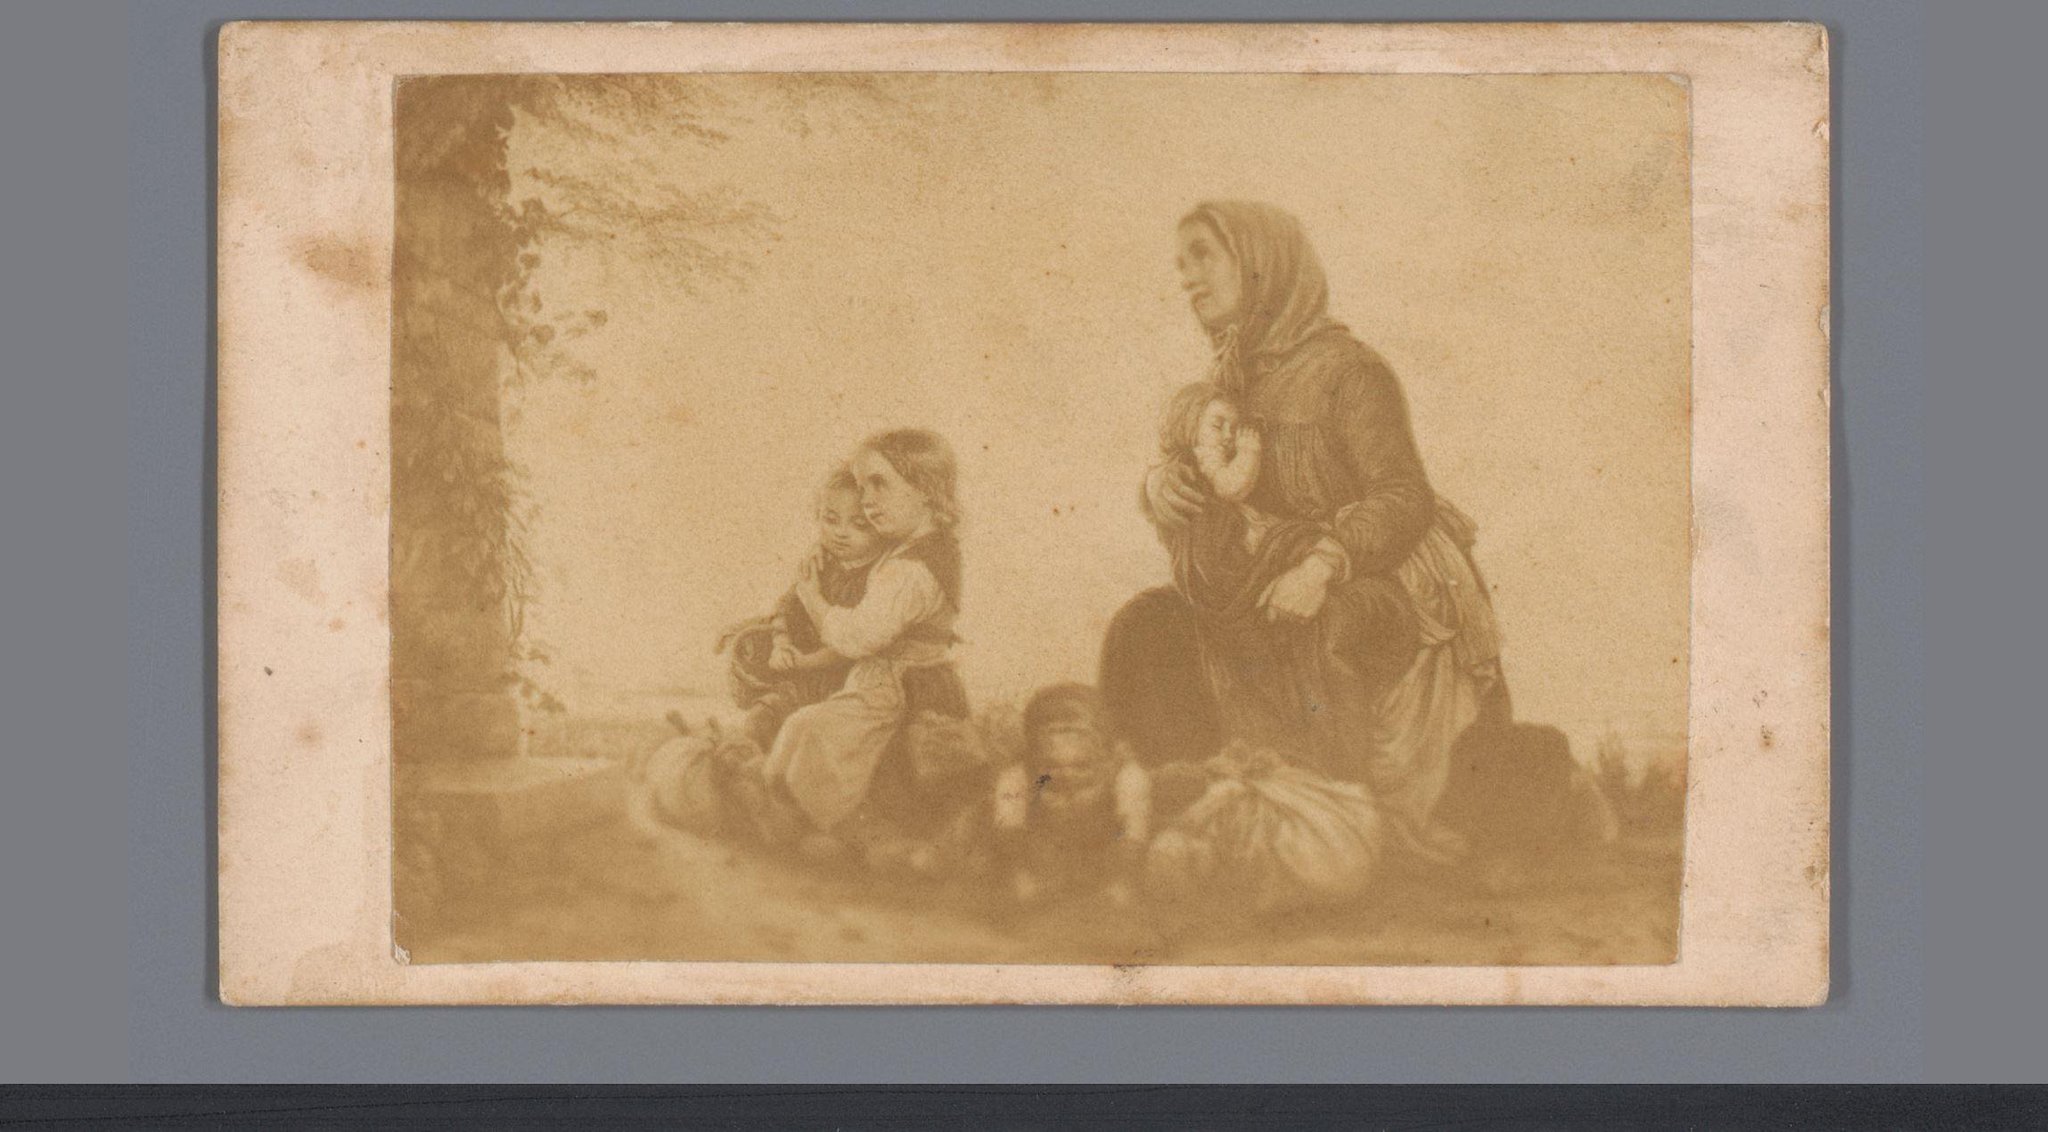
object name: carte de visite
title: Fotoreproductie van Das Gebet der Wittwe van Johann Georg Meyer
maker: Anonymous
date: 1855-1885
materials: cardboard, paper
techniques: albumen print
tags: mother and child(ren), woman and child(ren) (family group)